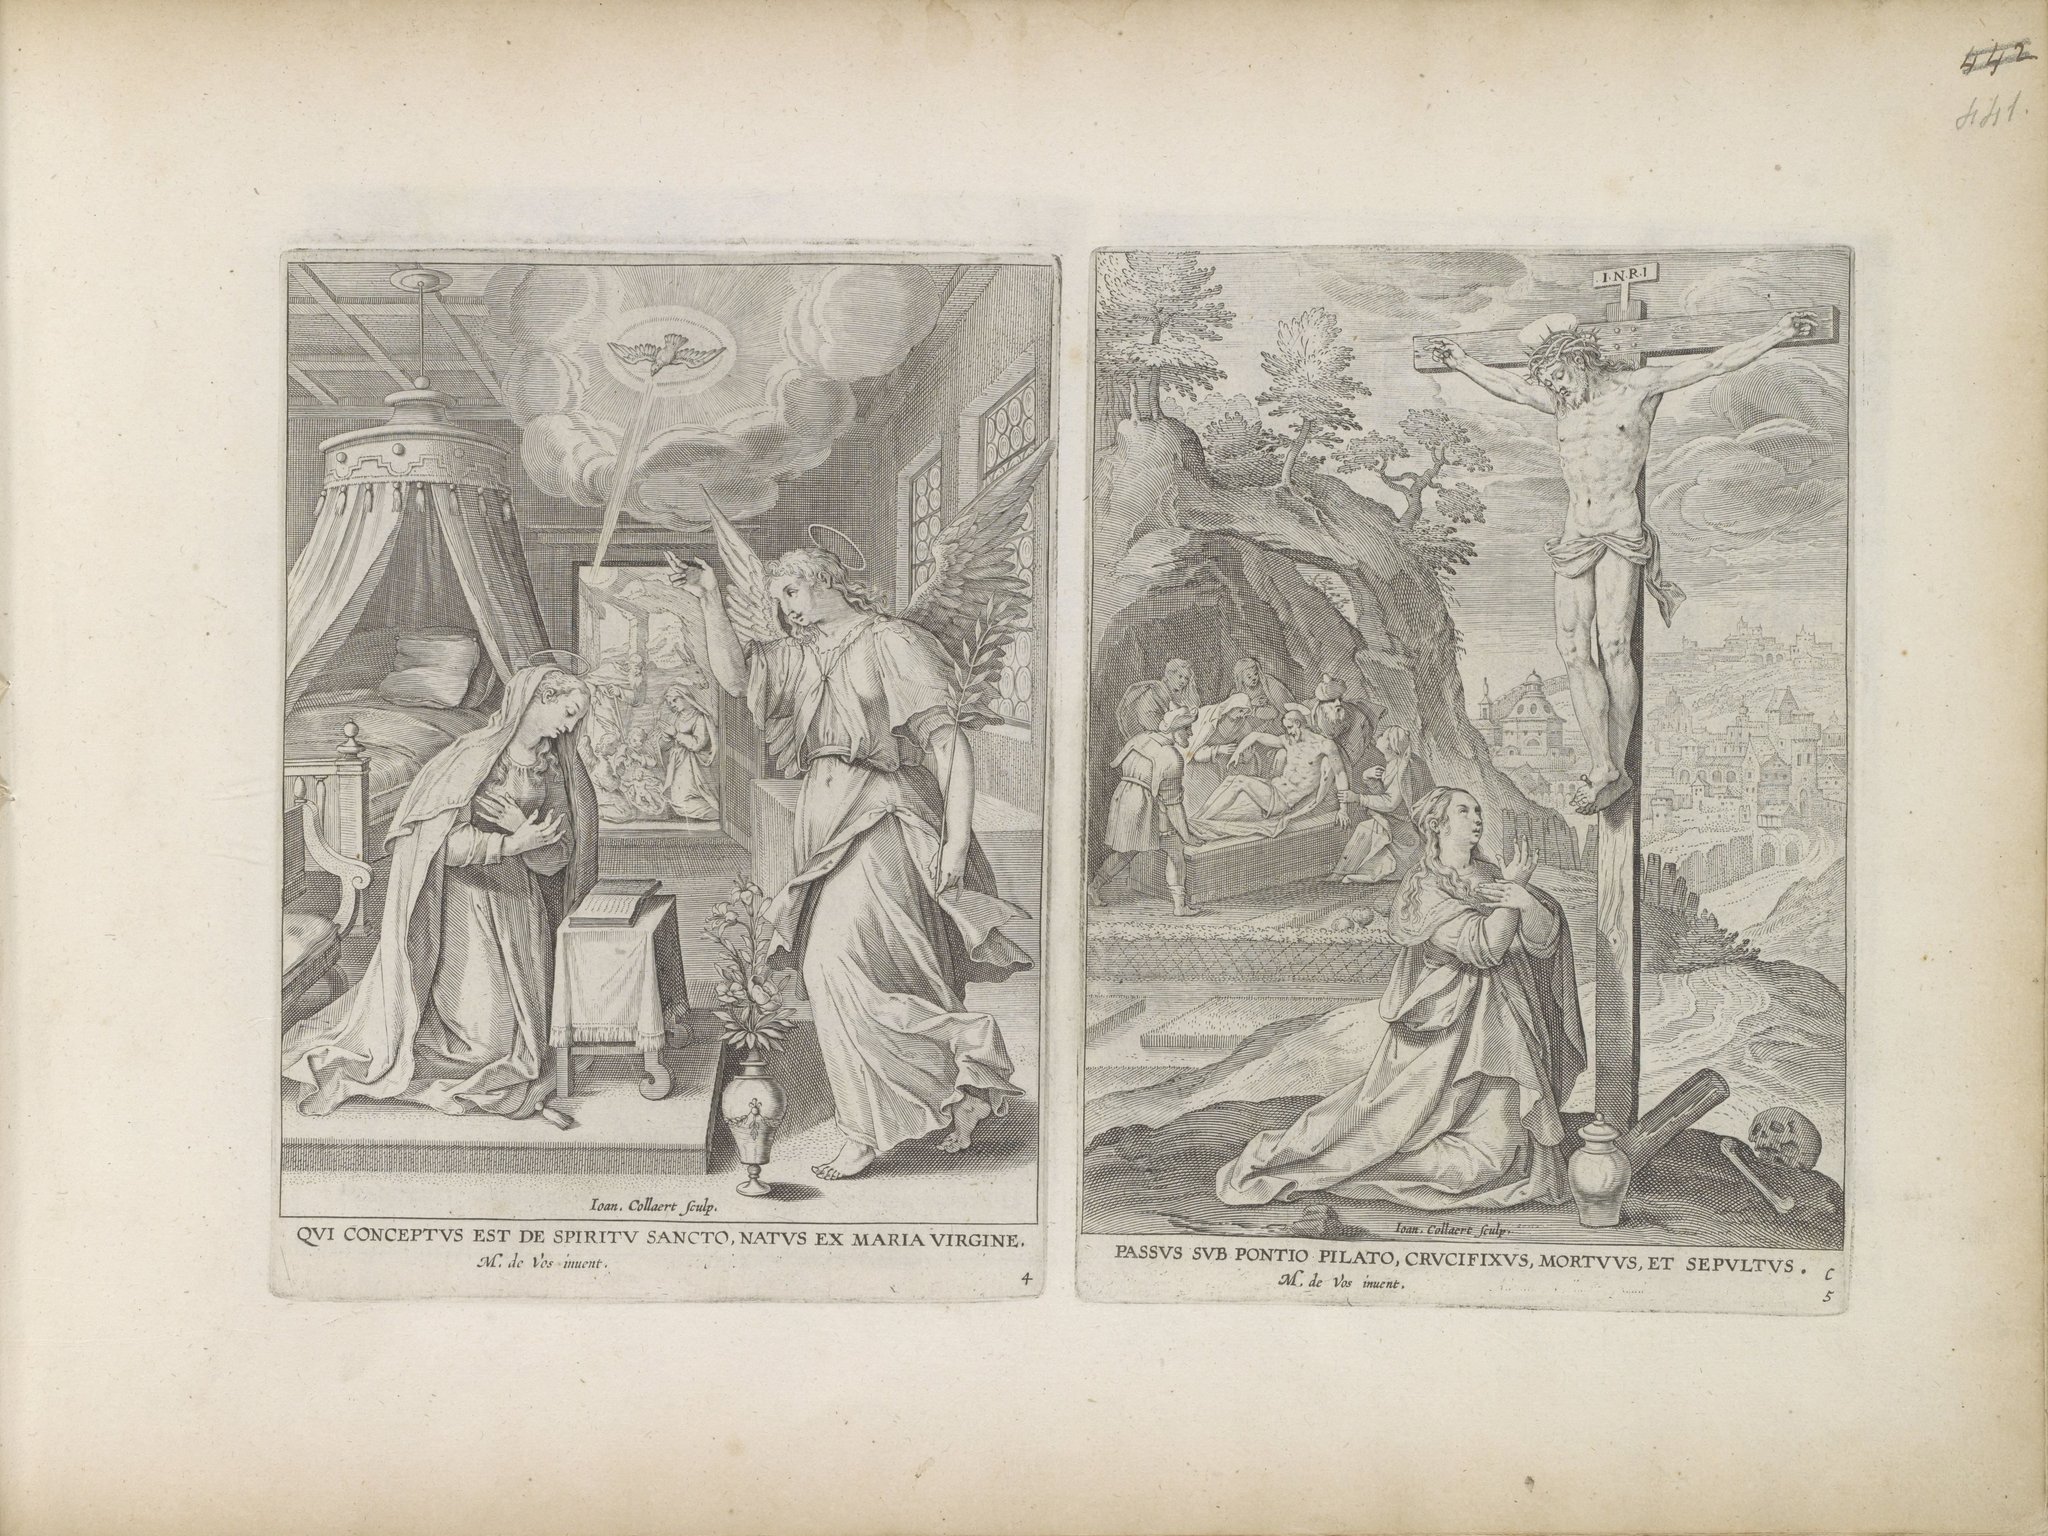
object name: album leaf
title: Passus sub Pontio Pilato crucifixus mortuus et sepultus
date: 1570-1618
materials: paper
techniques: engraving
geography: amsterdam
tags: christ's entombment (possibly by angels), crucified christ with mary magdalene, who usually weeps and embraces the cross, 'passus sub pontio pilato, crucifixus, mortuus et sepultus est' ~ articles of faith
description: Illustratie van het vierde geloofsartikel ([Christus] die geleden heeft onder Pontius Pilatus, is gekruisigd, gestorven en begraven) van de apostolische geloofsbelijdenis. Maria Magdalena knielt onder het kruis. Op de achtergrond de graflegging. Deze prent maakt deel uit van een album.